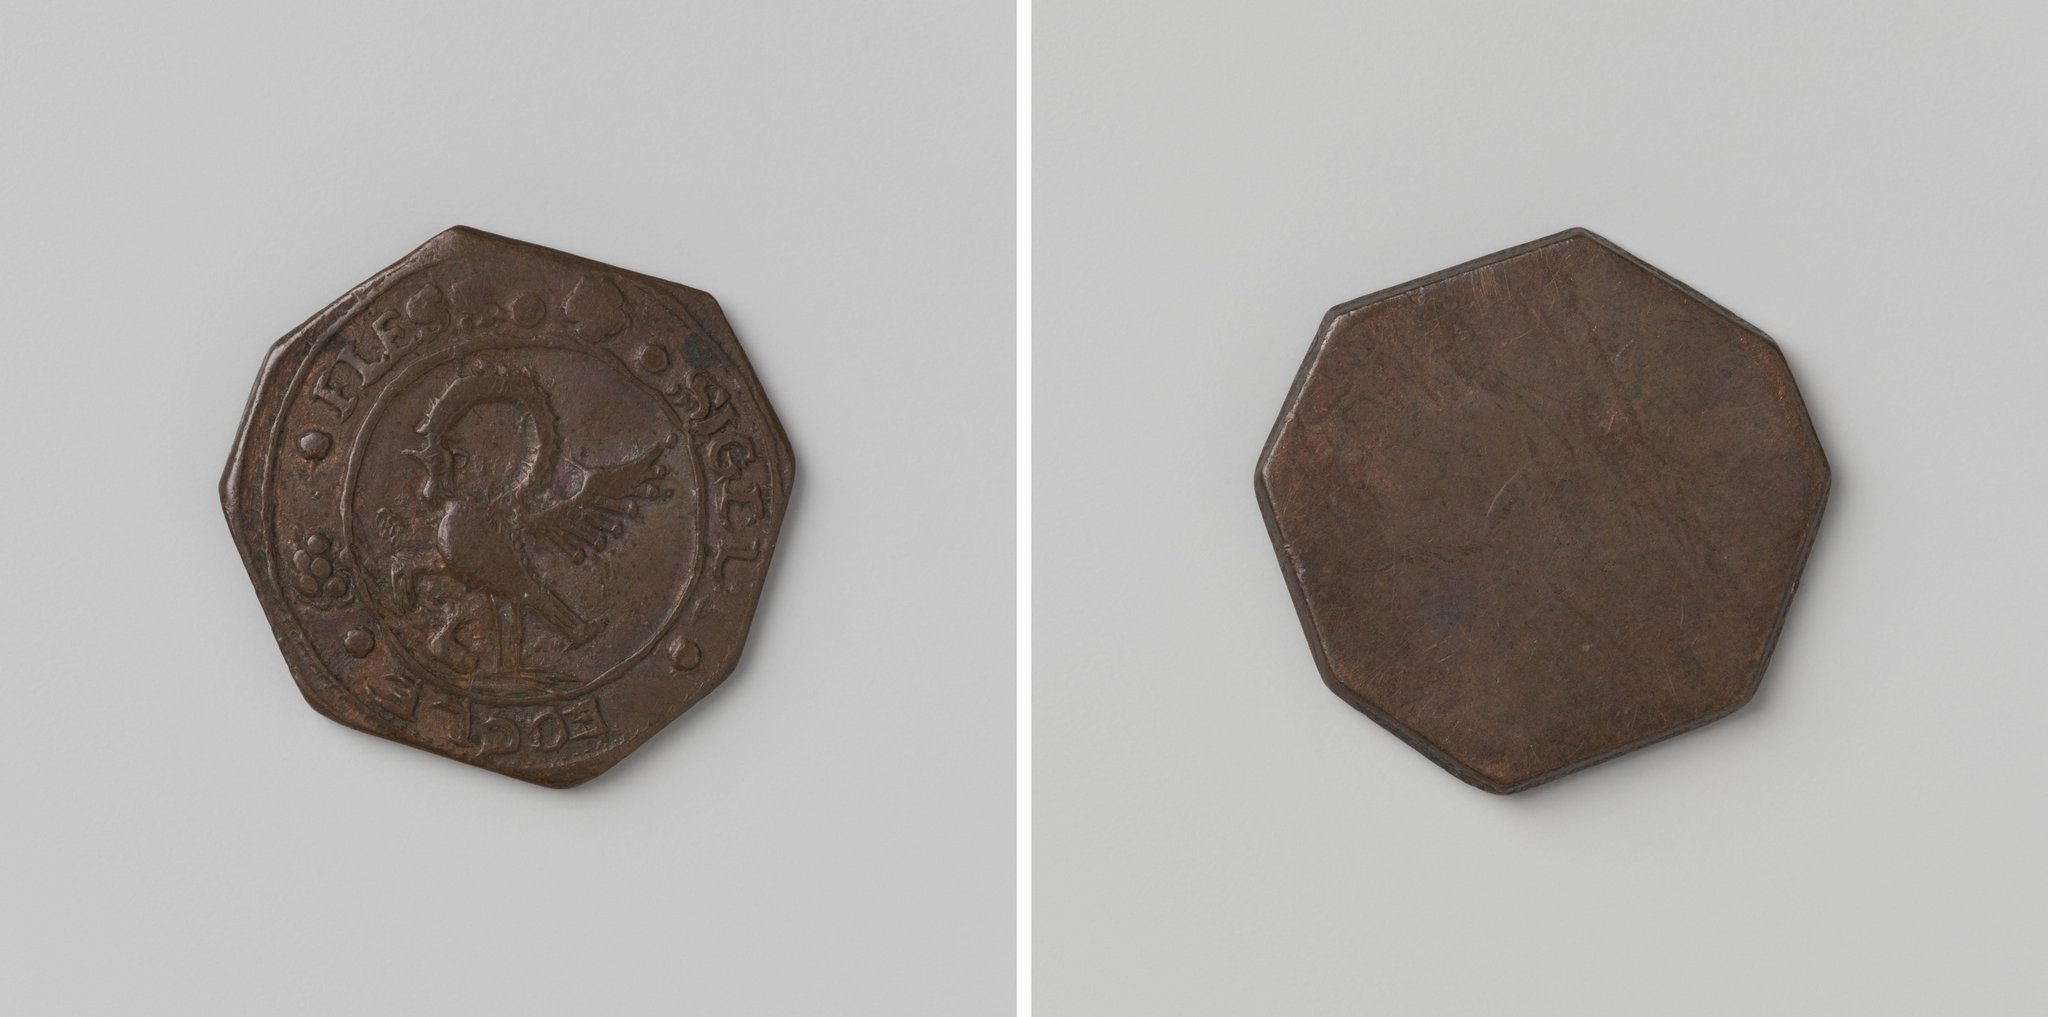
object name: devotional medal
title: Waalse gemeente van Vlissingen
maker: Anonymous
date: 1635-1750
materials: copper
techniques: snipping, striking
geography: flushing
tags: flushing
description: Eenzijdige koperen achthoekige penning. Voorzijde: pelikaan die jongen voedt met eigen bloed binnen omschrift. Keerzijde: blanco [mogelijk oudere, weggeslepen voorstelling].